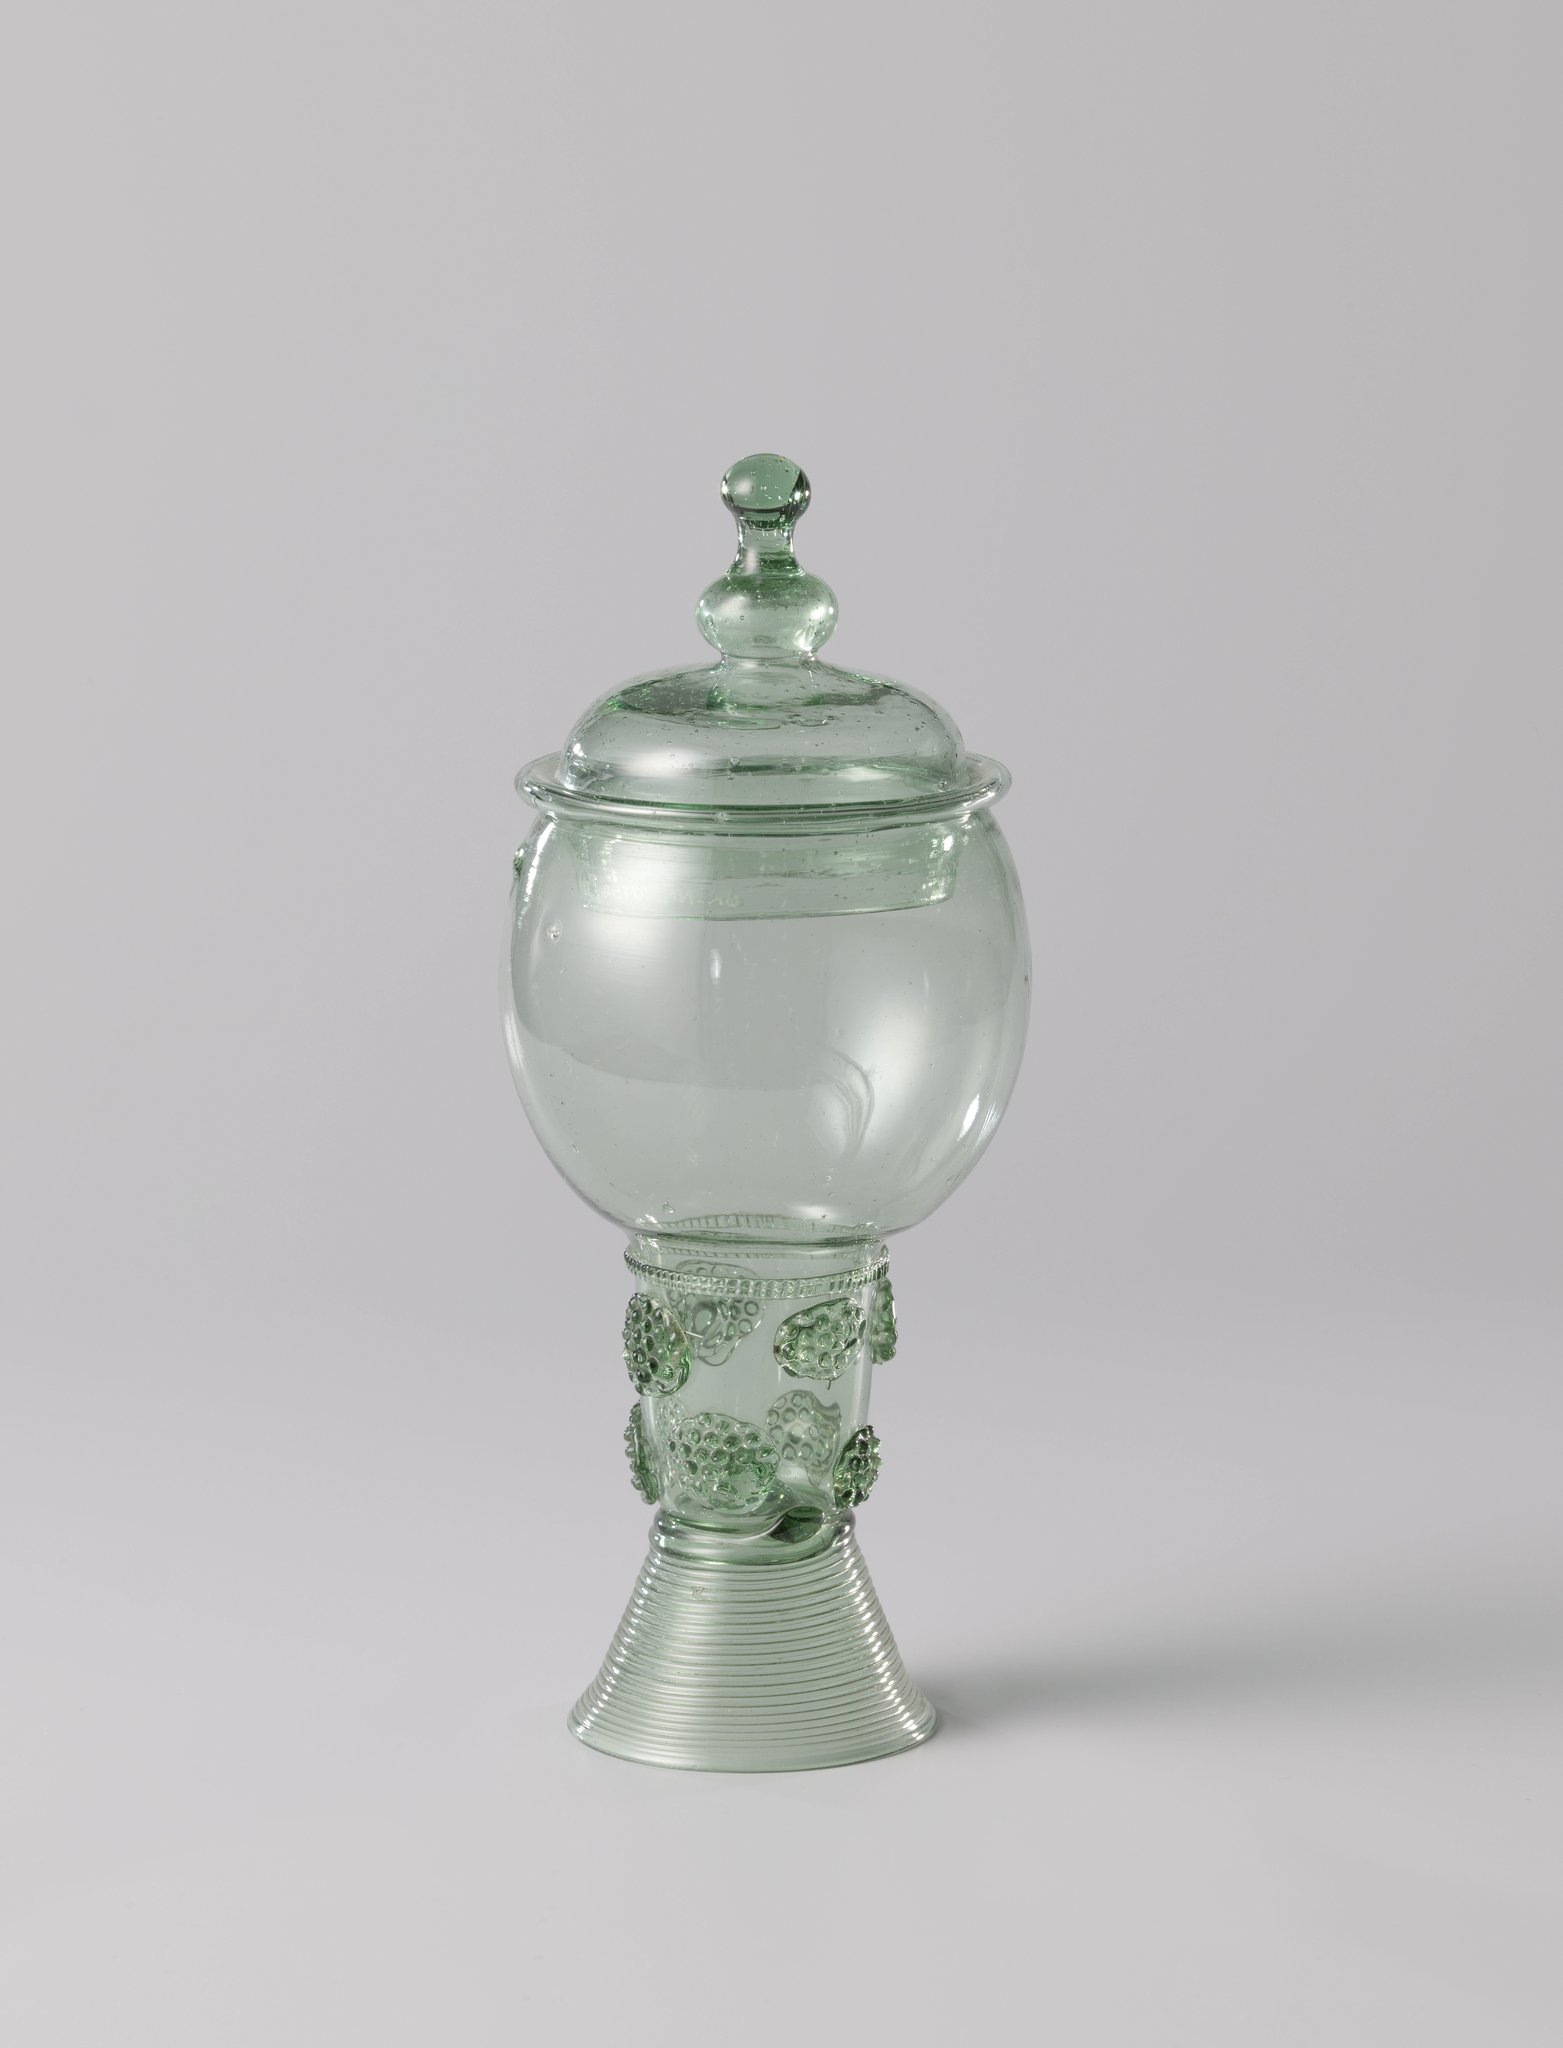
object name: roemer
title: Roemer met twee rijen braamnoppen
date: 1690-1800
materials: glass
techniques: glassblowing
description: Roemer met ingestoken bodem op hoge, conische, uit een draad gesponnen voet. De bolvormige kelk als één geheel geblazen met de stam, die bezet is met twee rijen braamnoppen. De overgang van de kelk naar de stam aangegeven door een geribde draad.